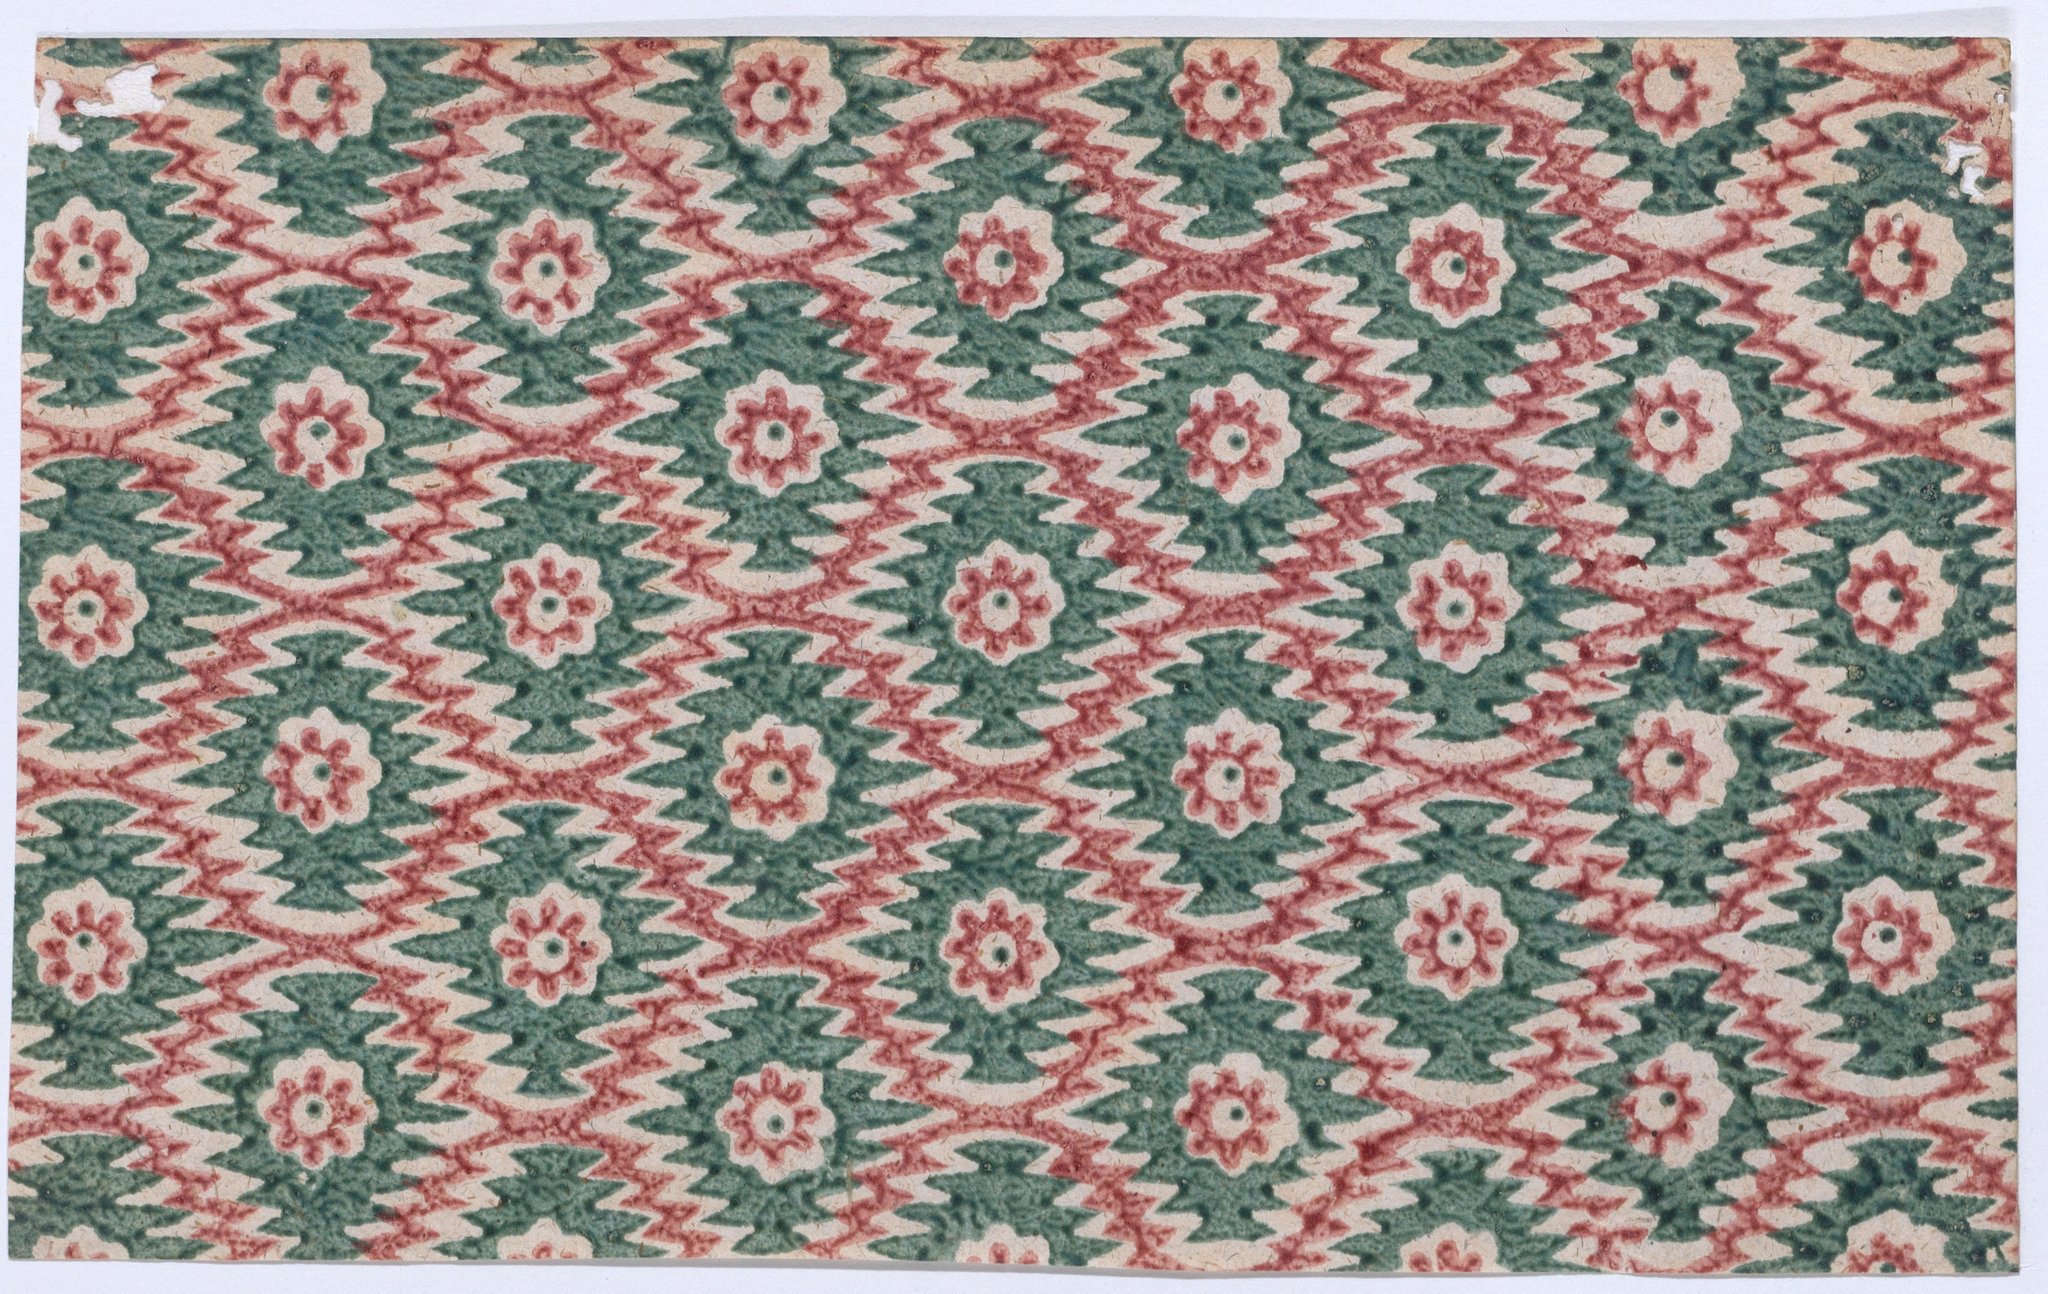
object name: print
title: Sheet with overall pattern of flowers and organic shapes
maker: Anonymous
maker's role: artist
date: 1801-1900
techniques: relief print